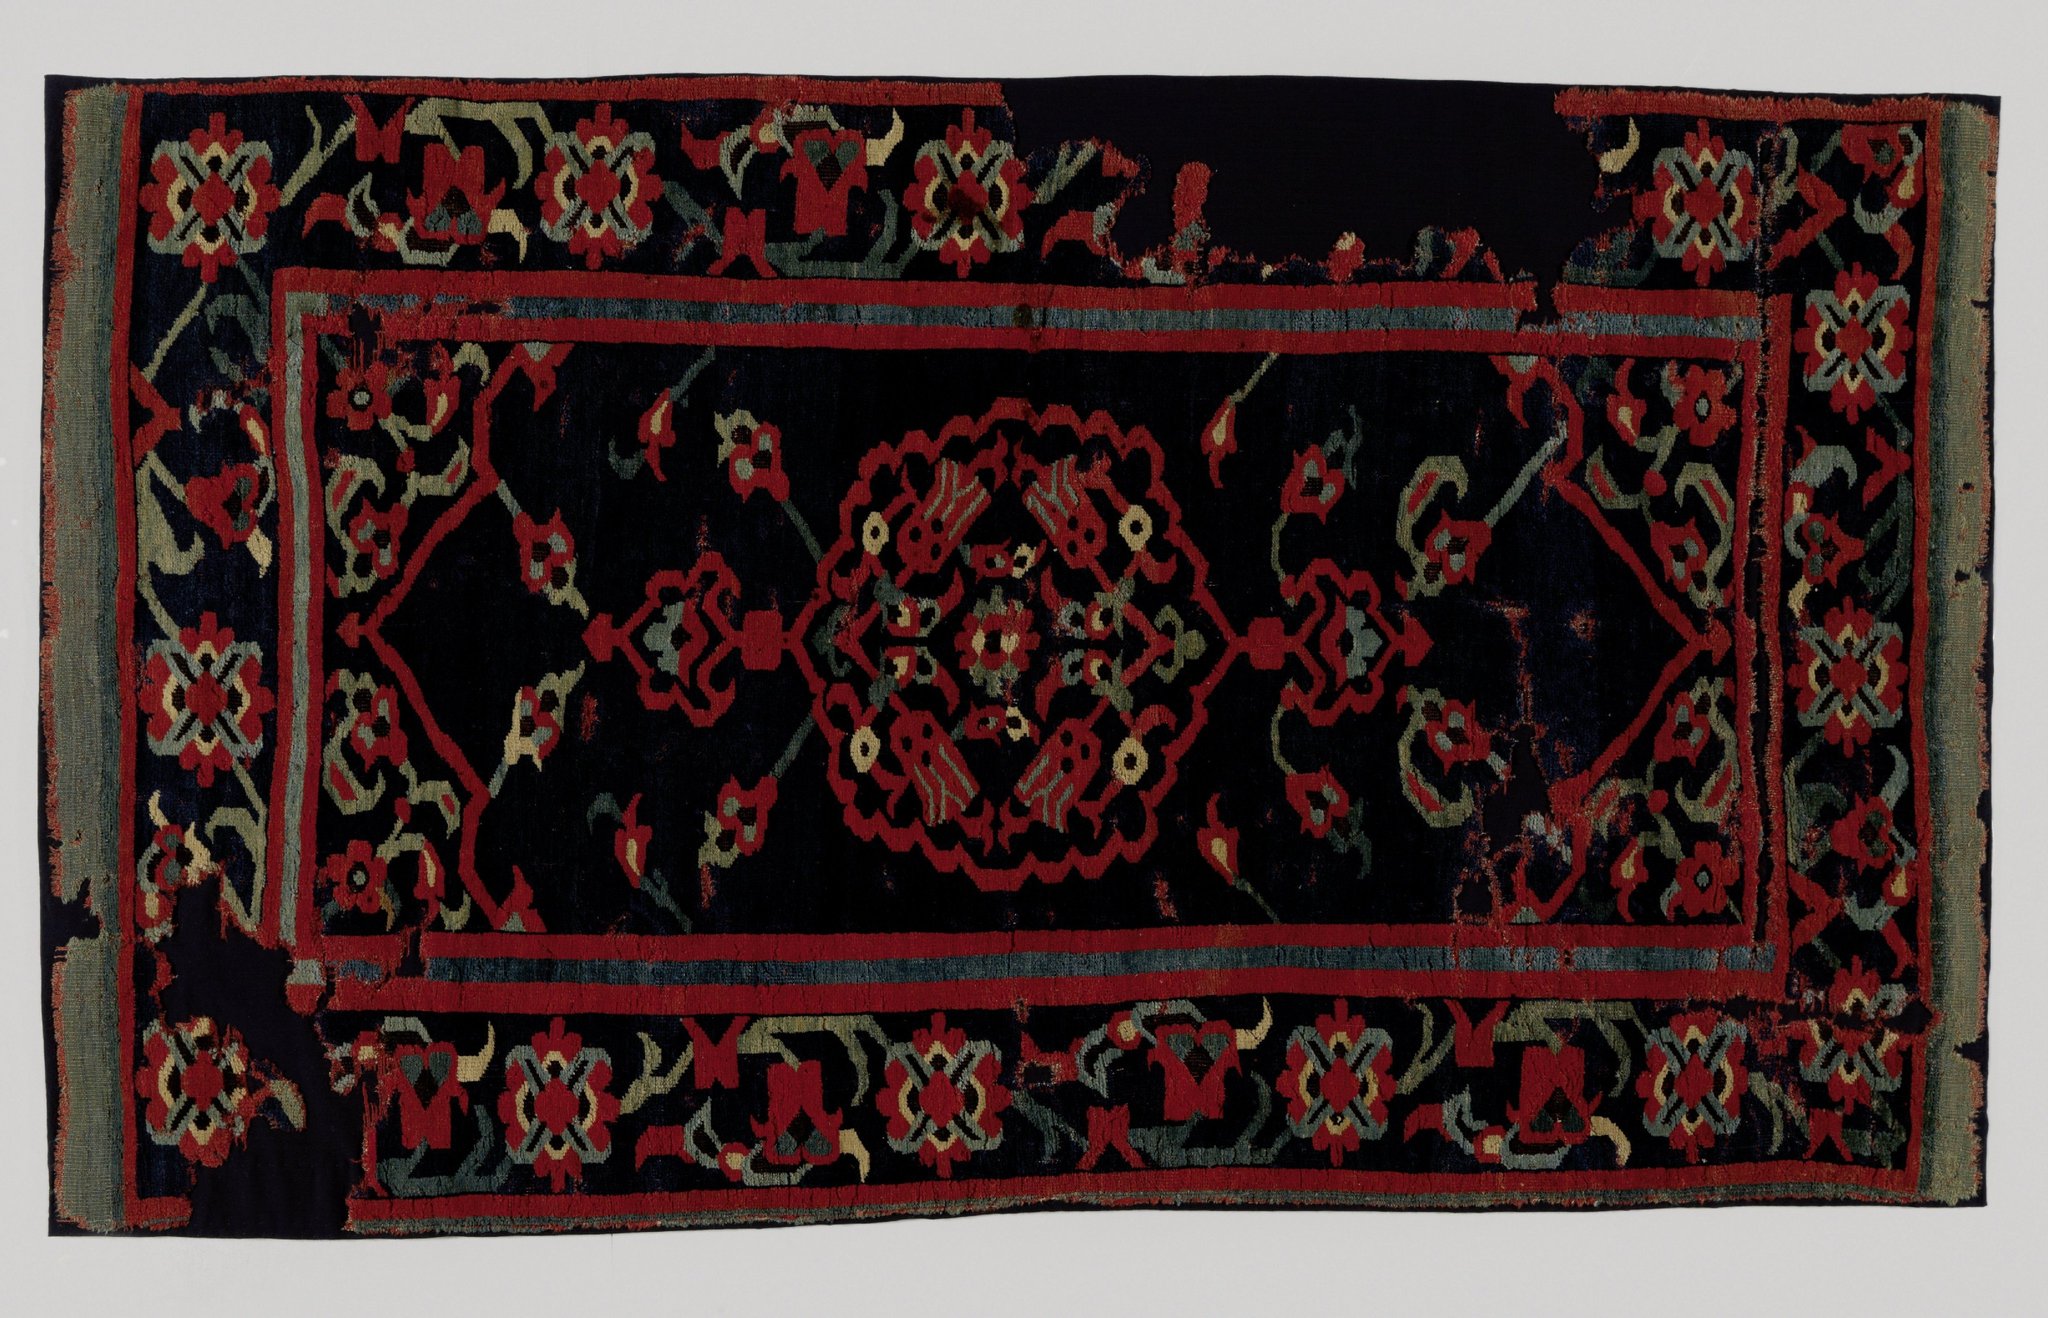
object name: tapijt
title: Medaillonkleed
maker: Anonymous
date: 1600-1609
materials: cotton, wool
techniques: knotting, weave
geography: konya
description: Medaillonkleed met Ghiordes-knoop: Op een diepblauwe fond een gelobd medaillon met rode contour, bekroond aan boven- en onderzijde met een arabesk-palmet. De rand bestaat uit een diepblauw fond met gebroken lopende rank met afwisselend rozet- en kelkbloem in rood, blauw, wit, groen en zwart.